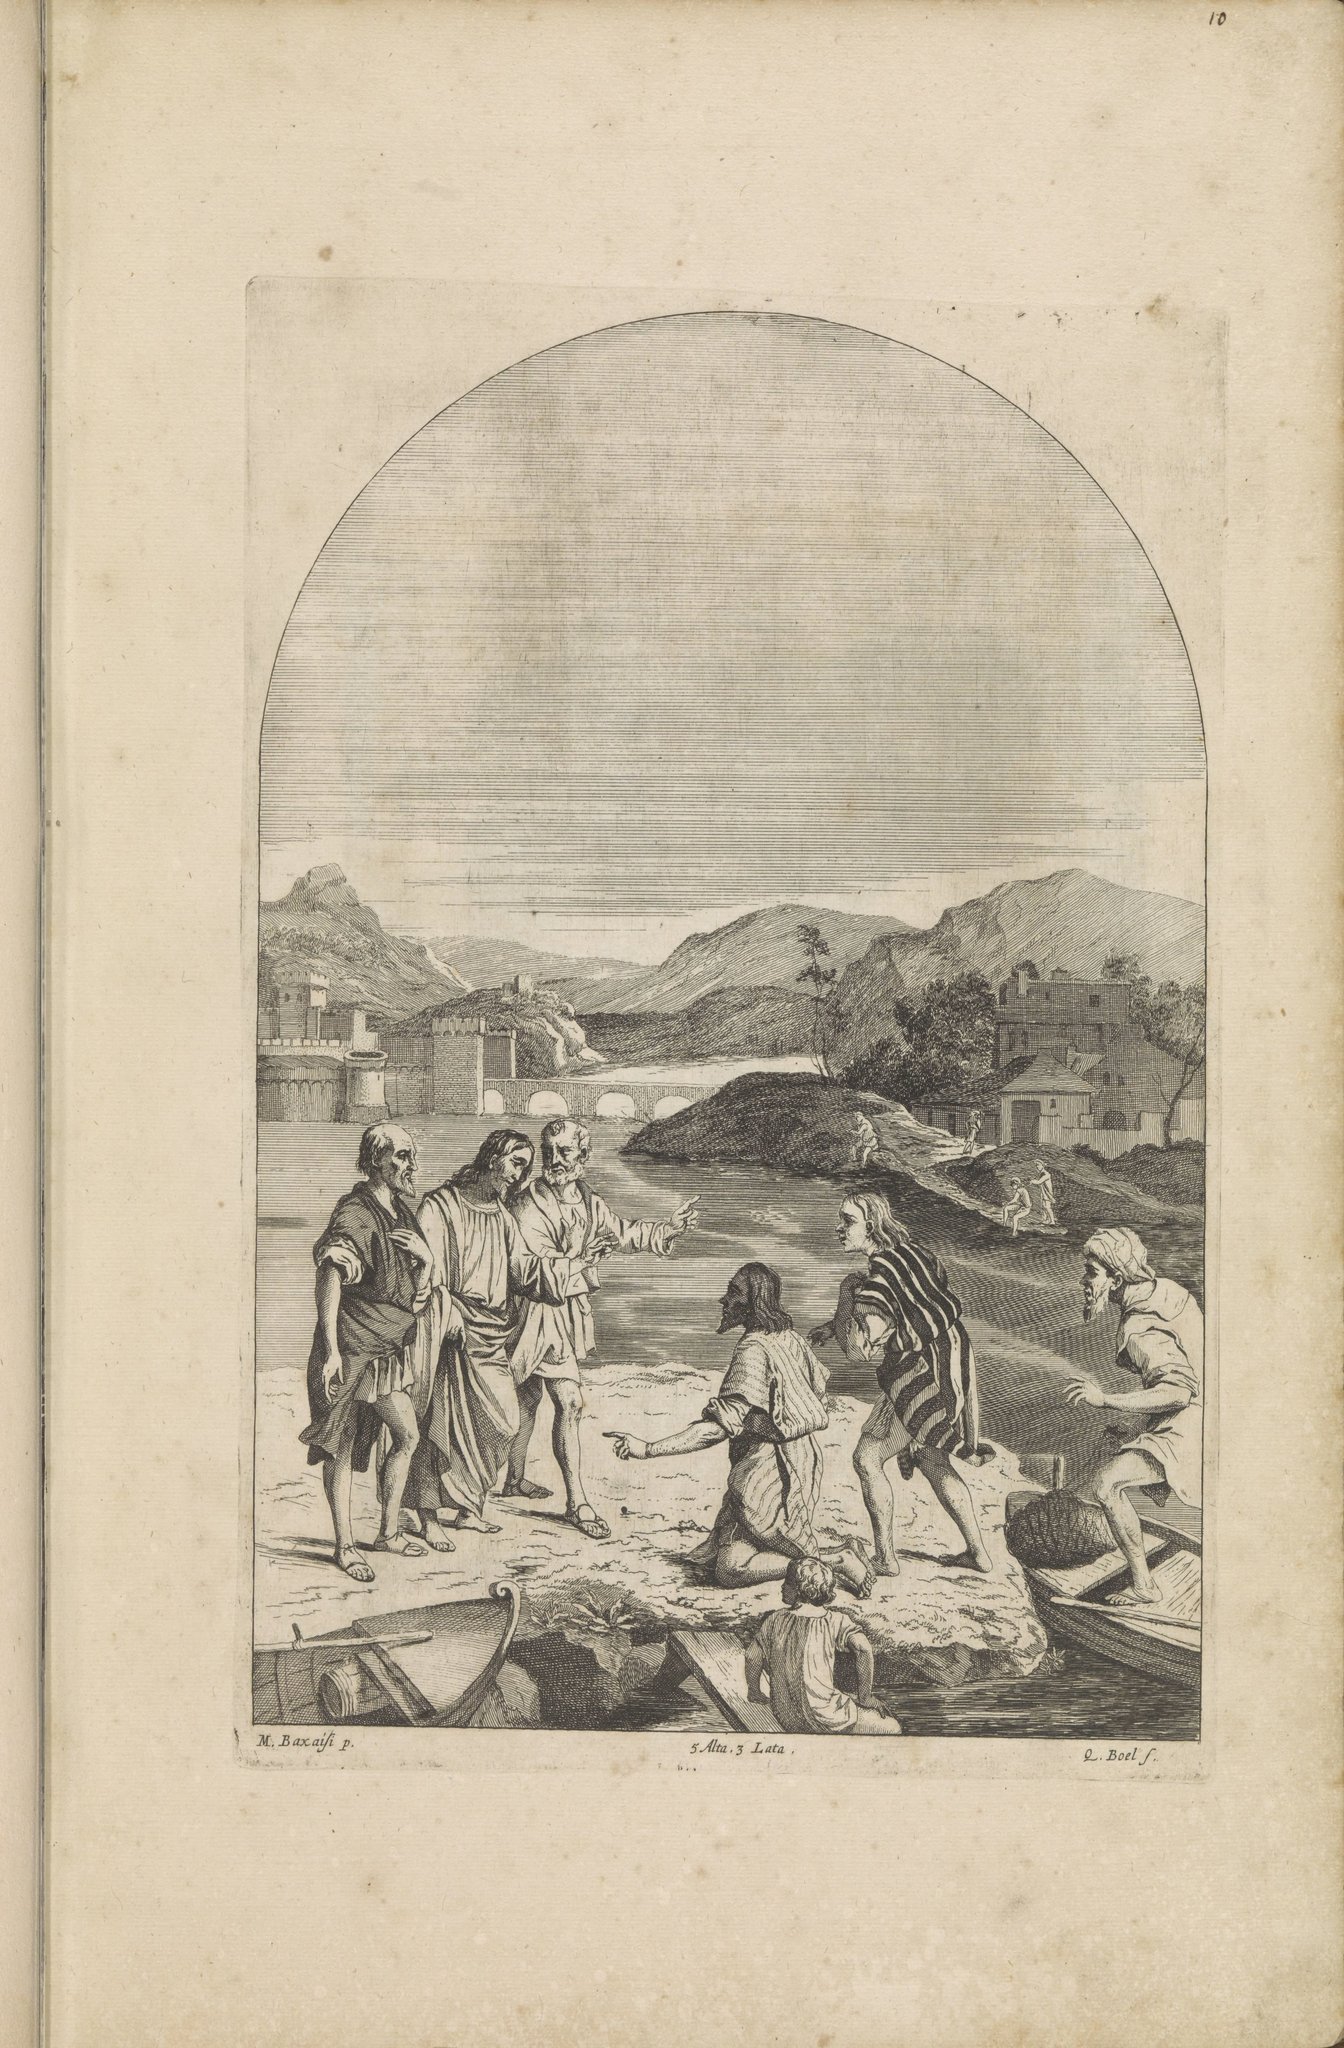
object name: album leaf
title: Roeping van Jakobus en Johannes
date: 1660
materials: paper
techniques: etching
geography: italy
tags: calling of james and john, the sons of zebedee (matthew 4:21-22; mark 1:19-20; luke 5:10-11)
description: David Teniers heeft waarschijnlijk van alle schilderijen uit de collectie van Leopold Willem van Oostenrijk een olieverfstudie op doek of paneel vervaardigd (zgn. pasticcio), die als voorbeeld voor de prentmakers diende. Het is niet altijd duidelijk of de pasticci door hem zijn gemaakt of door zijn atelier. Niet alle pasticci zijn overgeleverd.